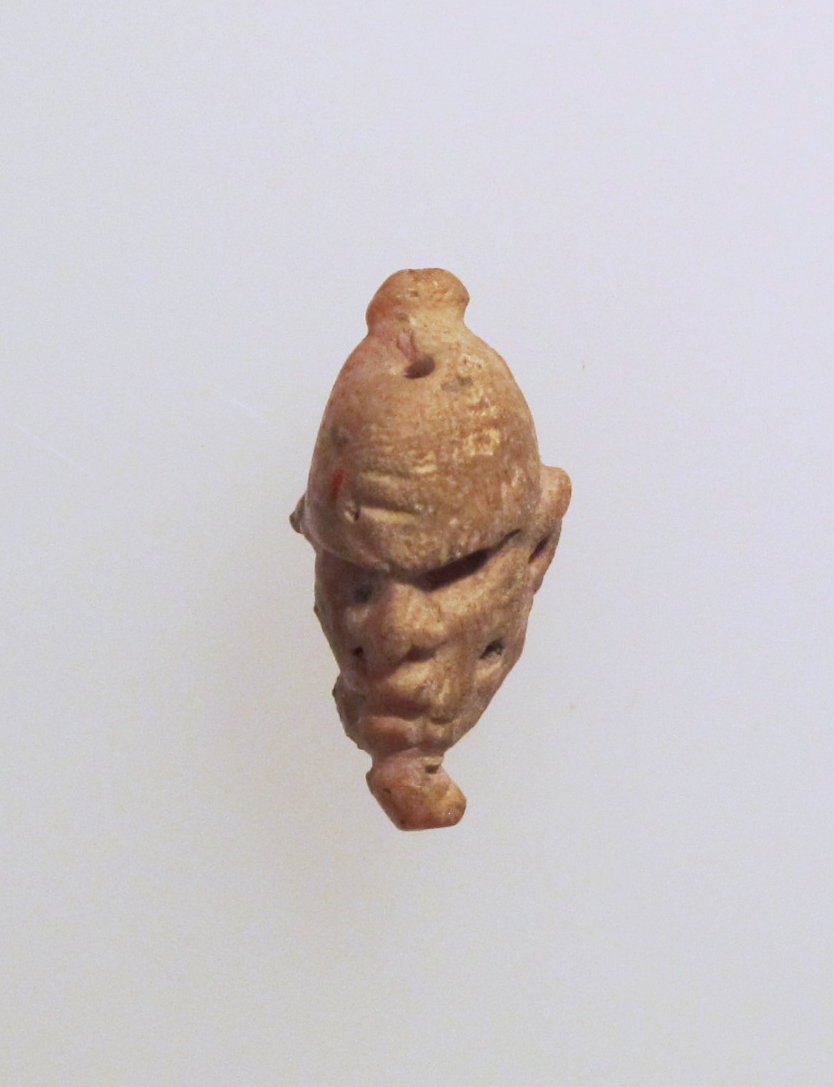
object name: mask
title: Glass head pendant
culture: carthaginian or phoenician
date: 300-101 BCE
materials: glass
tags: heads